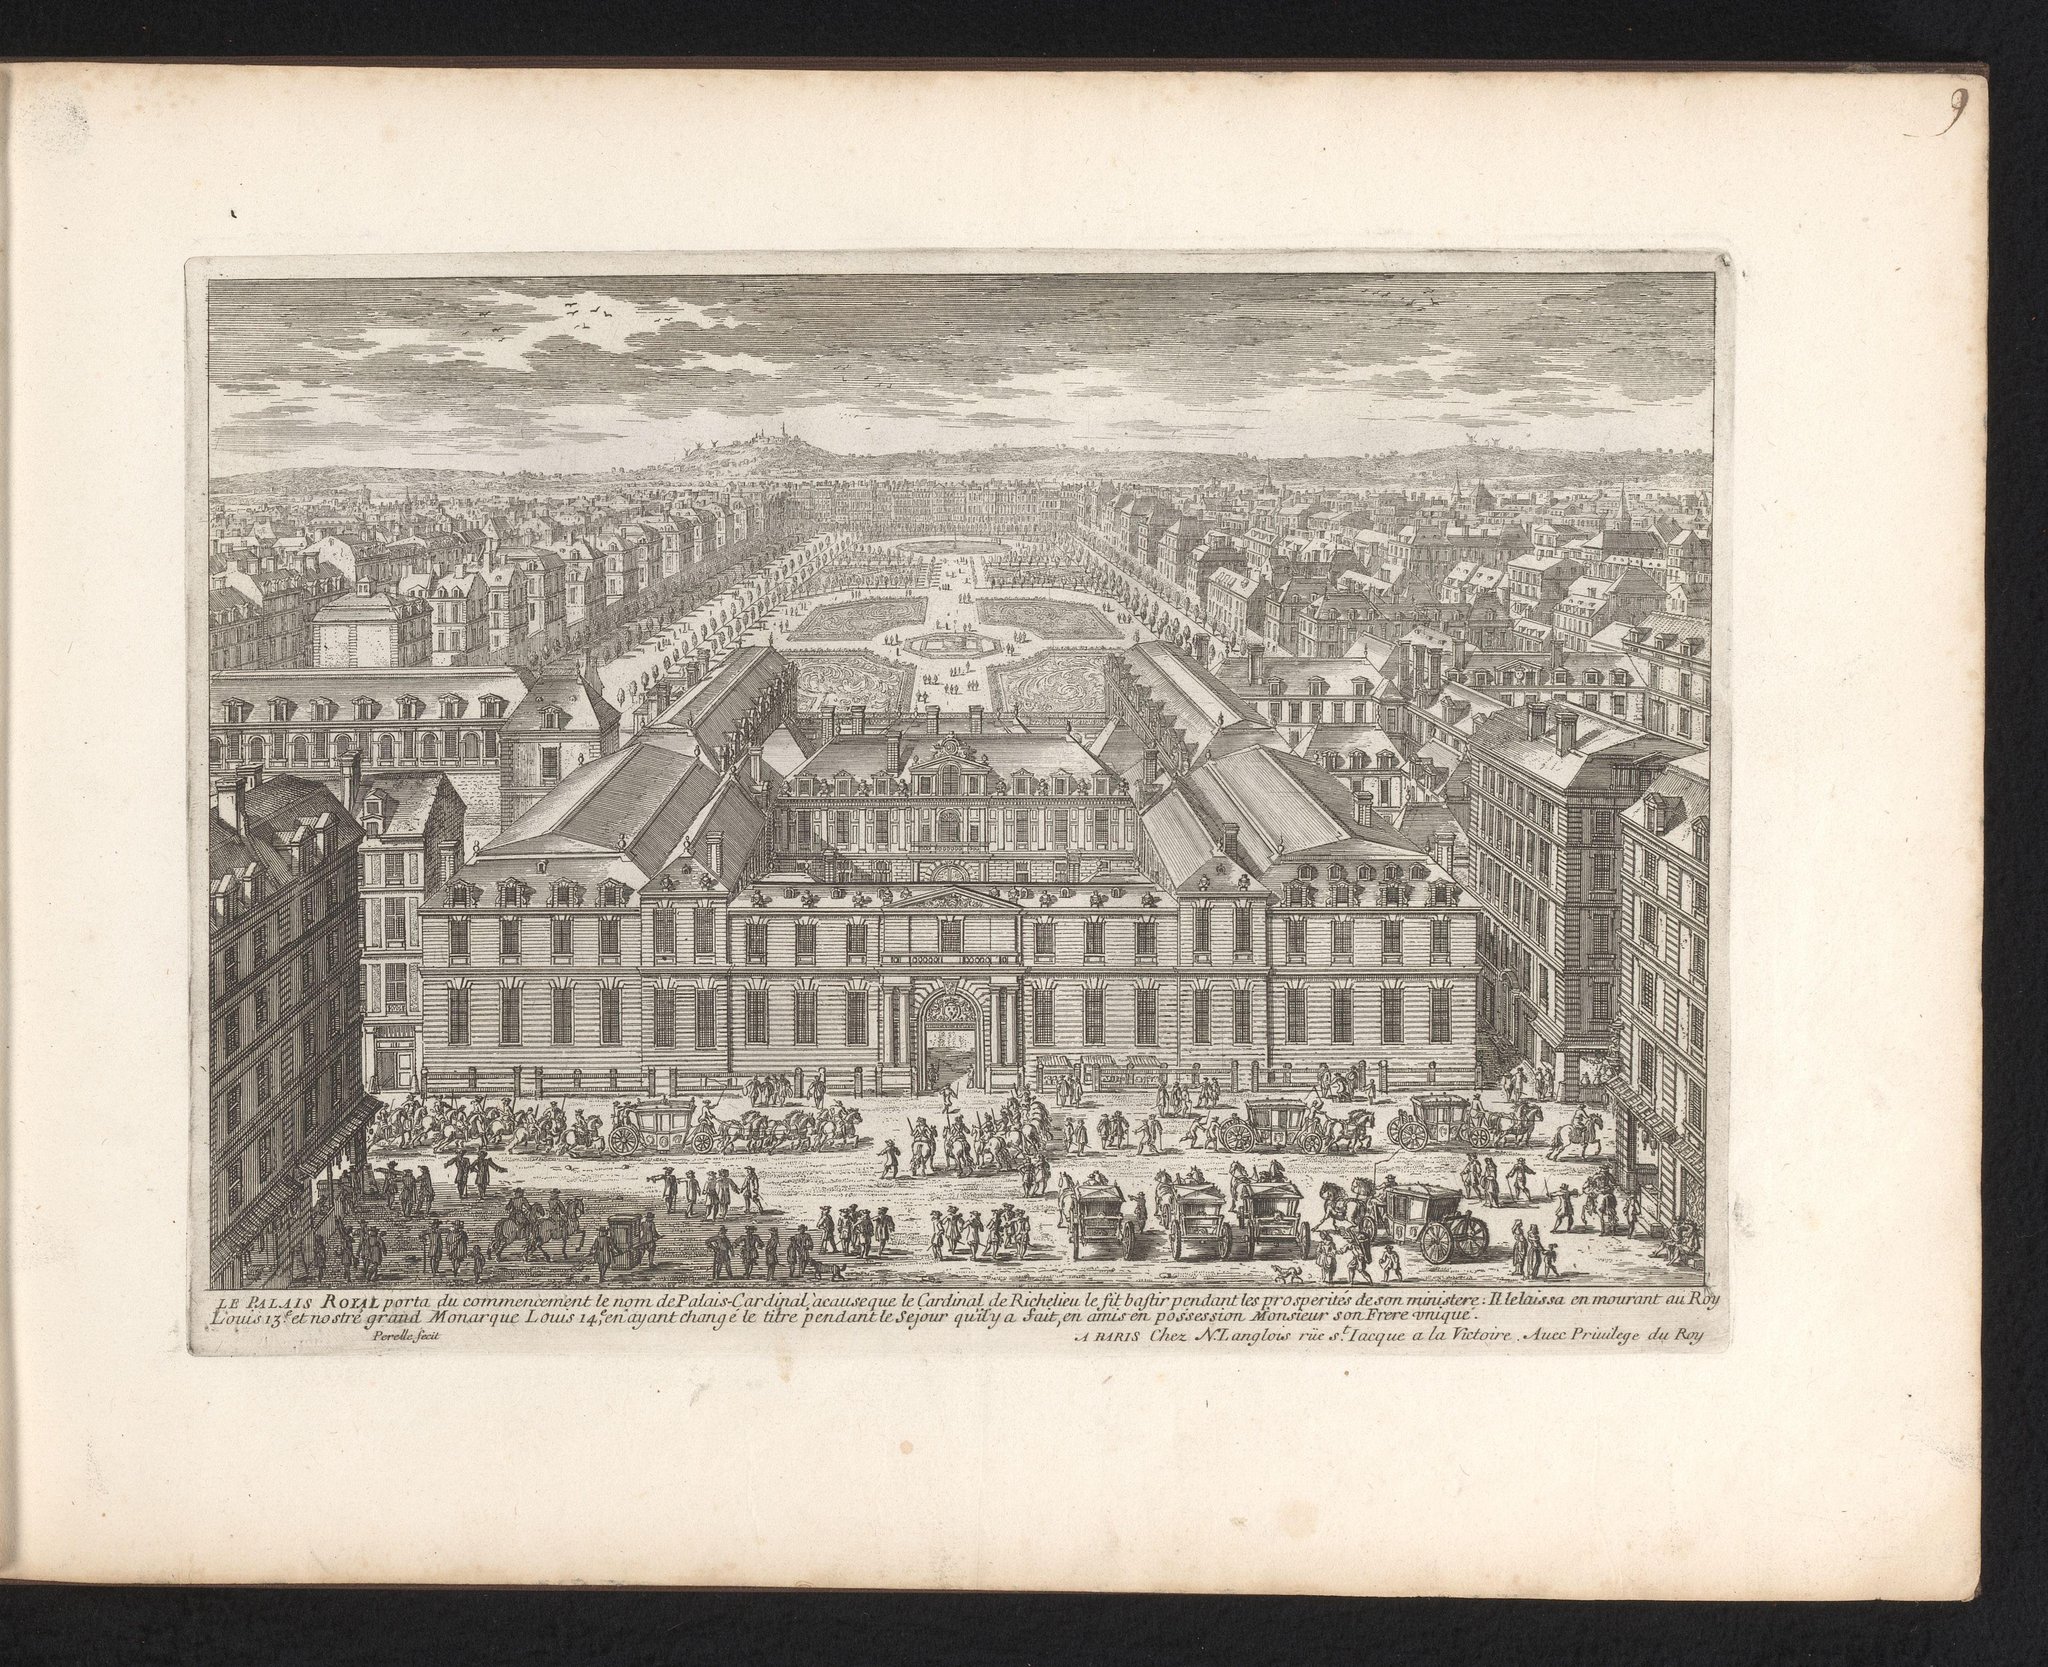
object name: album leaf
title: Gezicht op het Palais-Royal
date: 1660-1703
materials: paper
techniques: etching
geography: france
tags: palace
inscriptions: collector's mark: Lugt 2228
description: Prenten met het signatuur 'Perelle' kunnen zowel door vader Gabriel als door zonen Nicolas en Adam gemaakt zijn. De uitgevers vader en zoon Nicolas Langlois worden allebei vermeld als N. Langlois op hetzelfde adres.